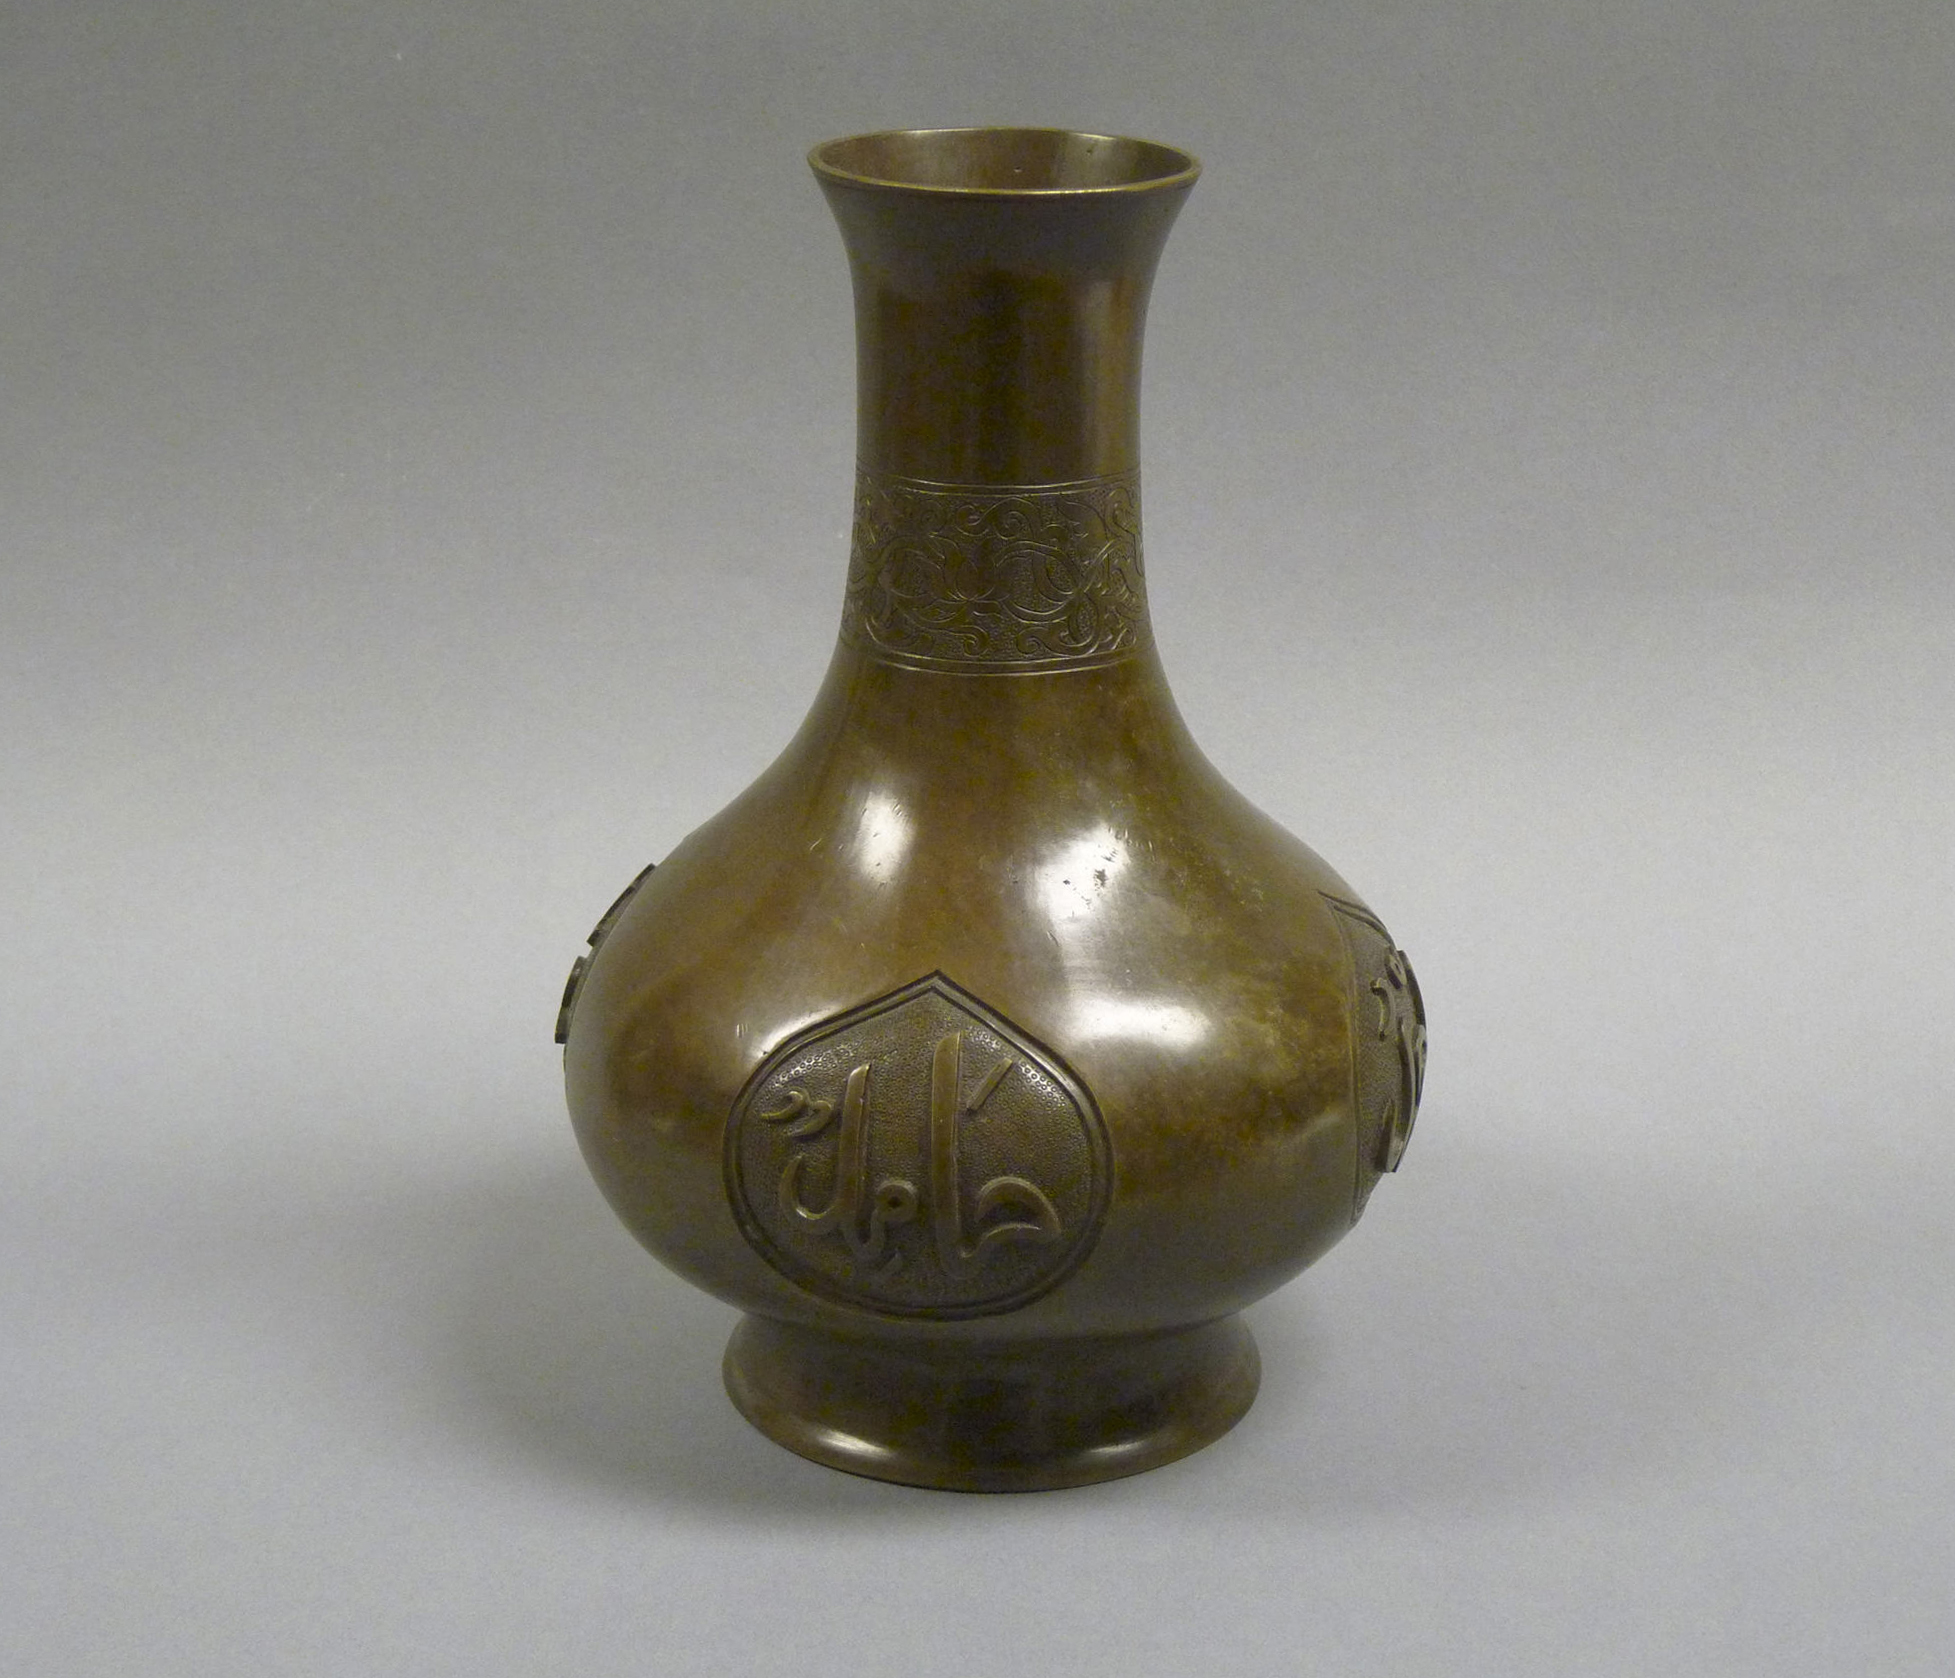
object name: vase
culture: chinese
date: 1701-1800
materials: bronze